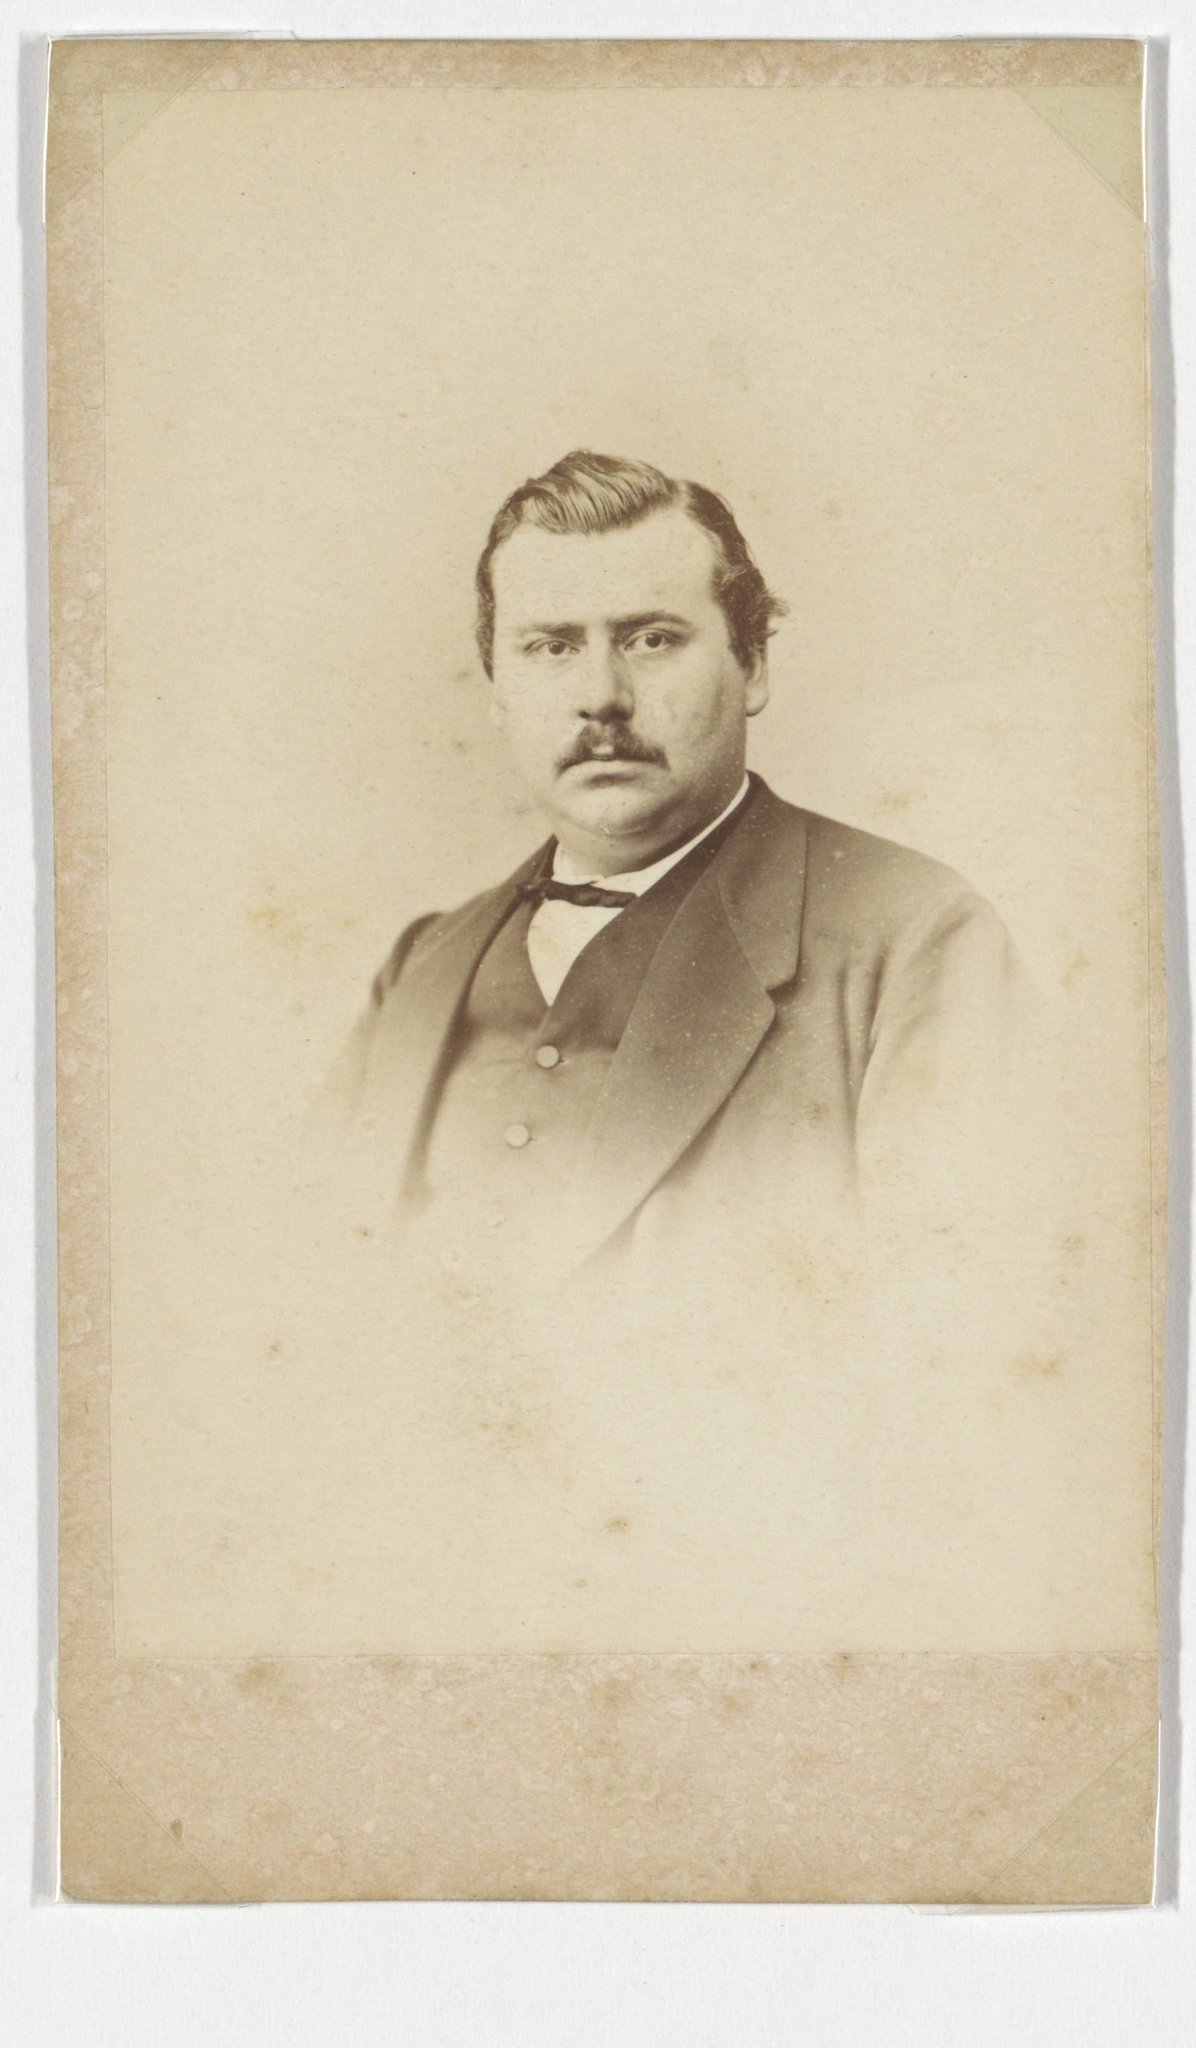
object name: photograph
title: Portret van een man met een snor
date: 1864-1890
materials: cardboard, paper, photographic support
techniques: albumen print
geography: amsterdam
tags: historical persons not known by name, amsterdam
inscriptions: name: ‘Atelier de Photographie & Photolithographie du Palais de l'Industrie à Amsterdam Sous la direction de Wegner & Mottu.’